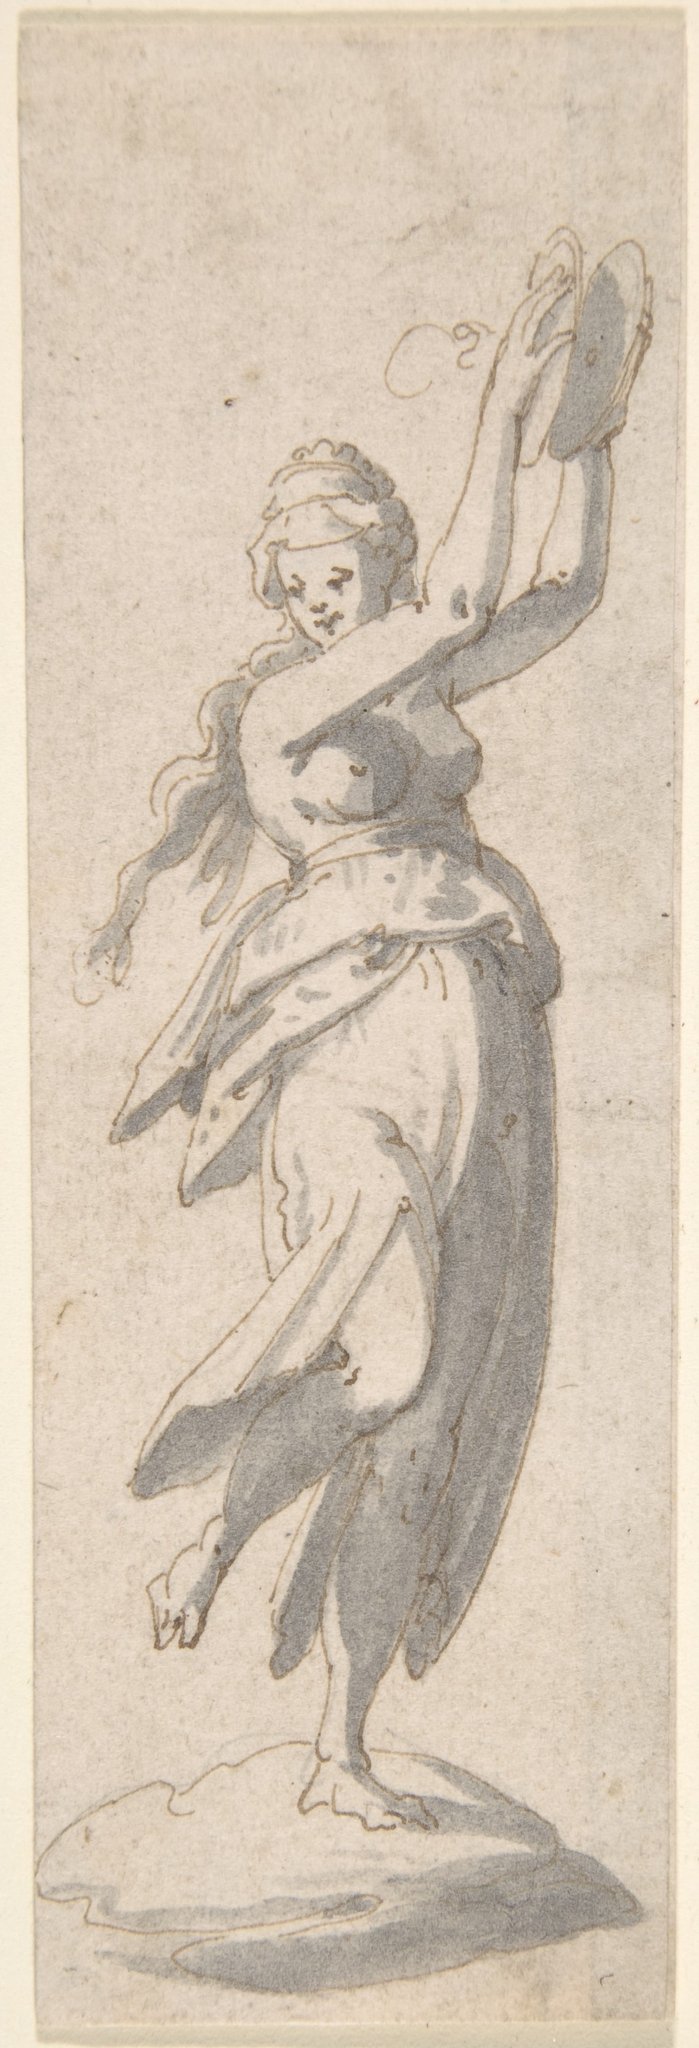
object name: drawing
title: Dancing Woman with Cymbals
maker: anonymous, italian, 17th century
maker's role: artist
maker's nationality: italian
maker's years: 1600-1700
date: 1601-1700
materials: ink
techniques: brush, pen, wash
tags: musical instruments,women,dancing